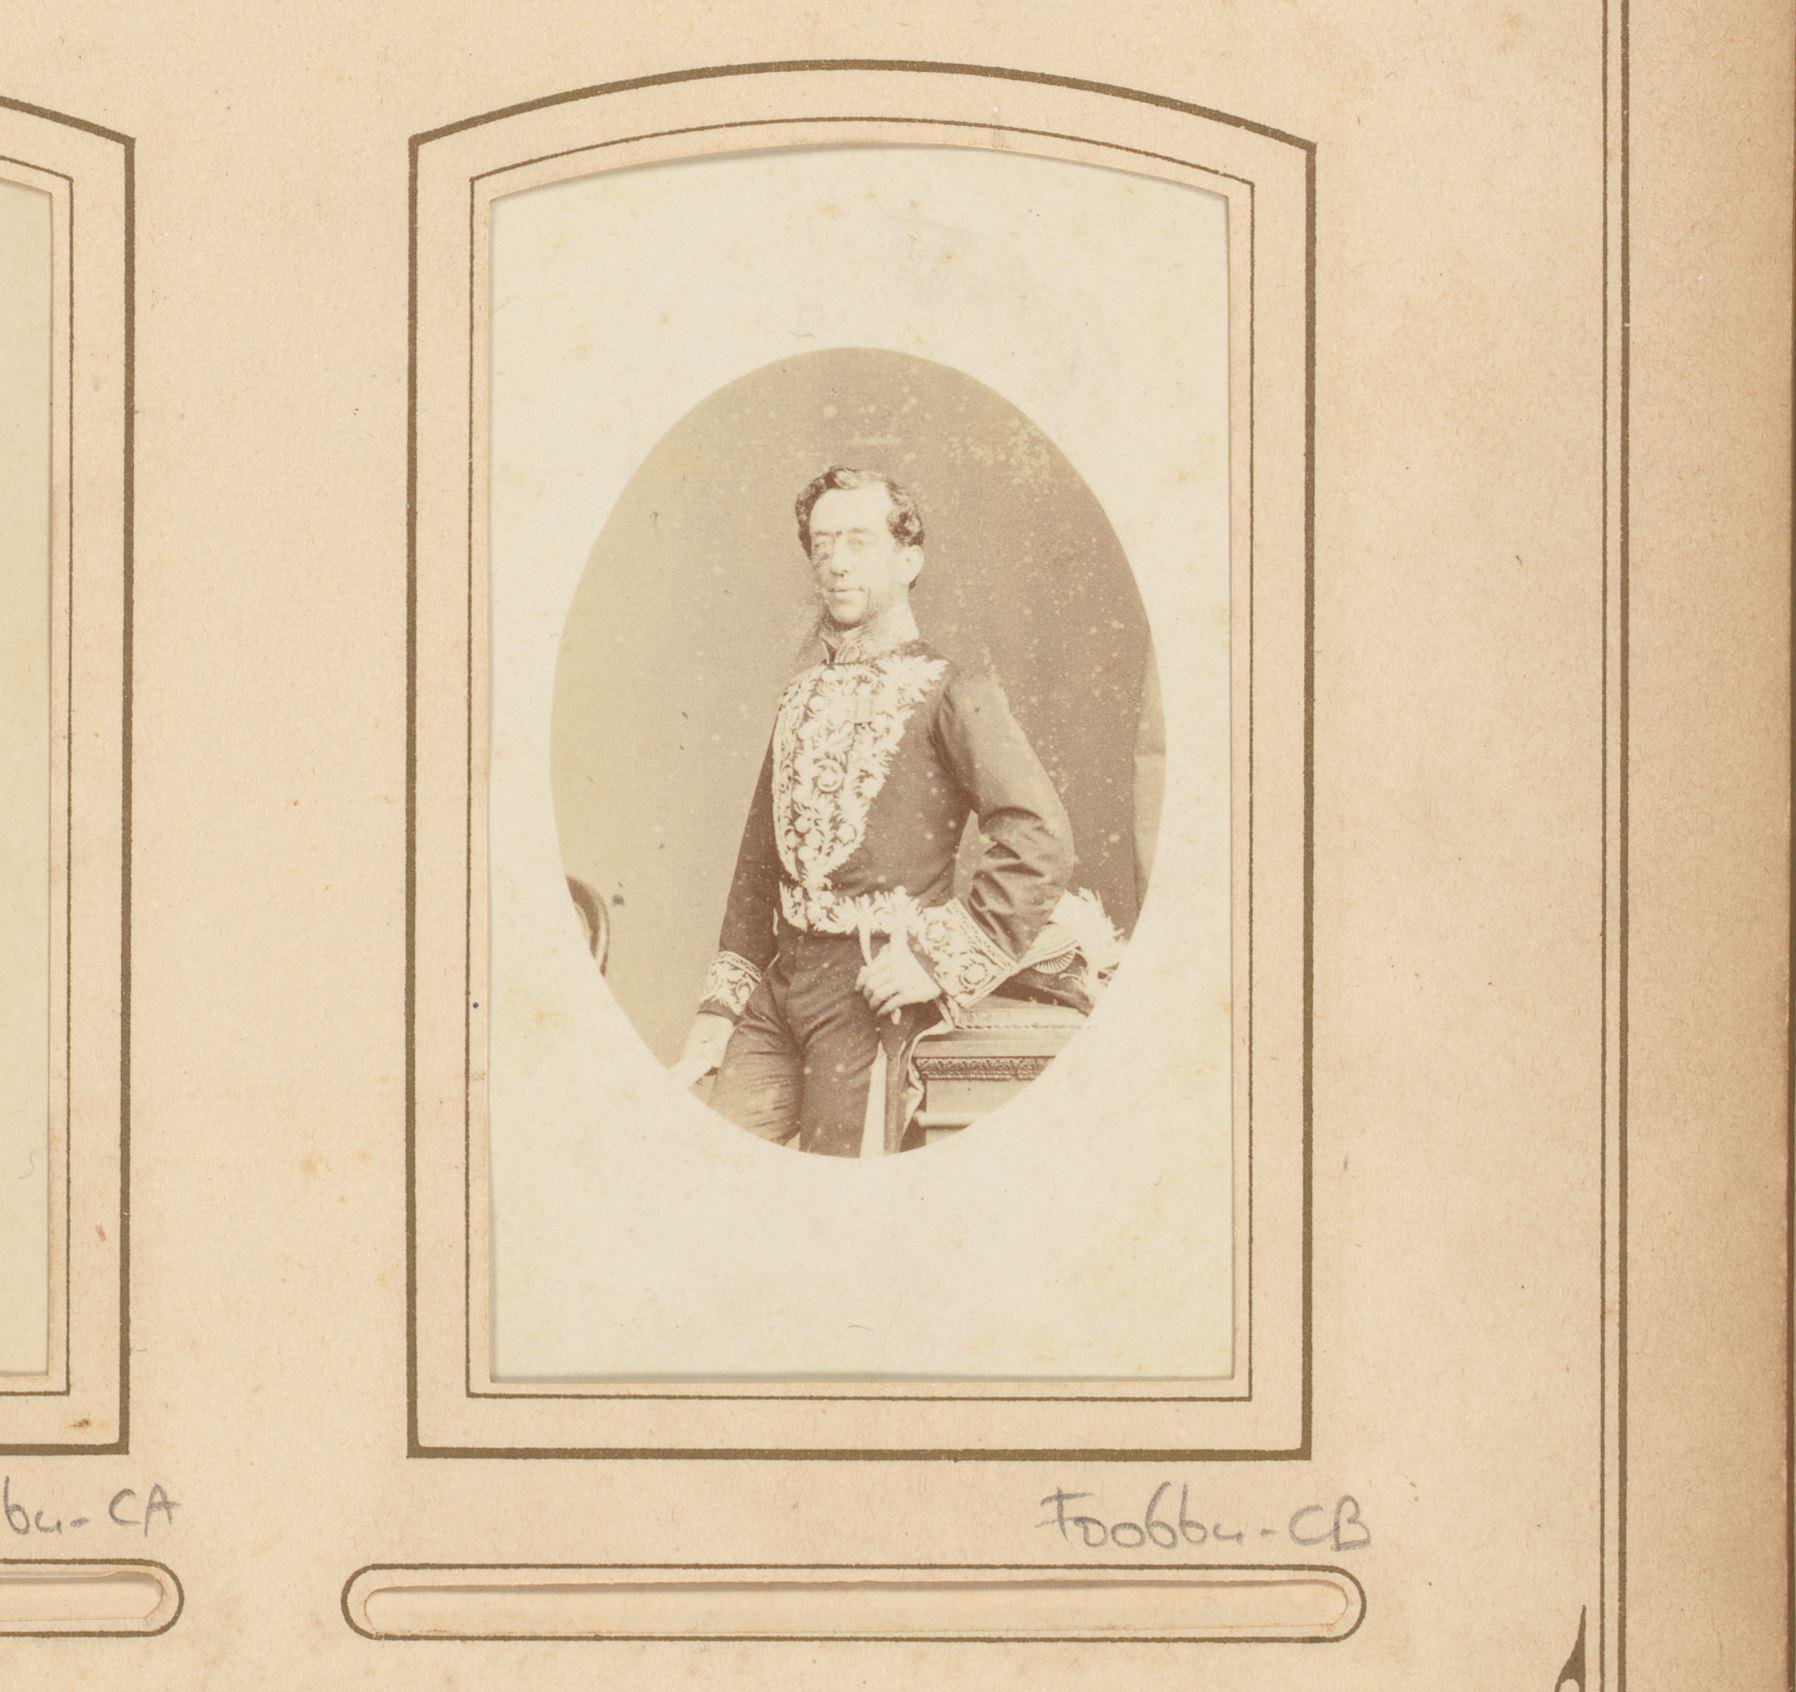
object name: photograph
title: Portret van een man in uniform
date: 1860-1880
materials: cardboard, photographic support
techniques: albumen print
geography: melbourne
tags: historical persons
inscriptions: inscription: ‘Johnstone o'Shannessy & Co./ Artist Photographers/ 3, Bourke St. East, Next the post office/ Melbourne’